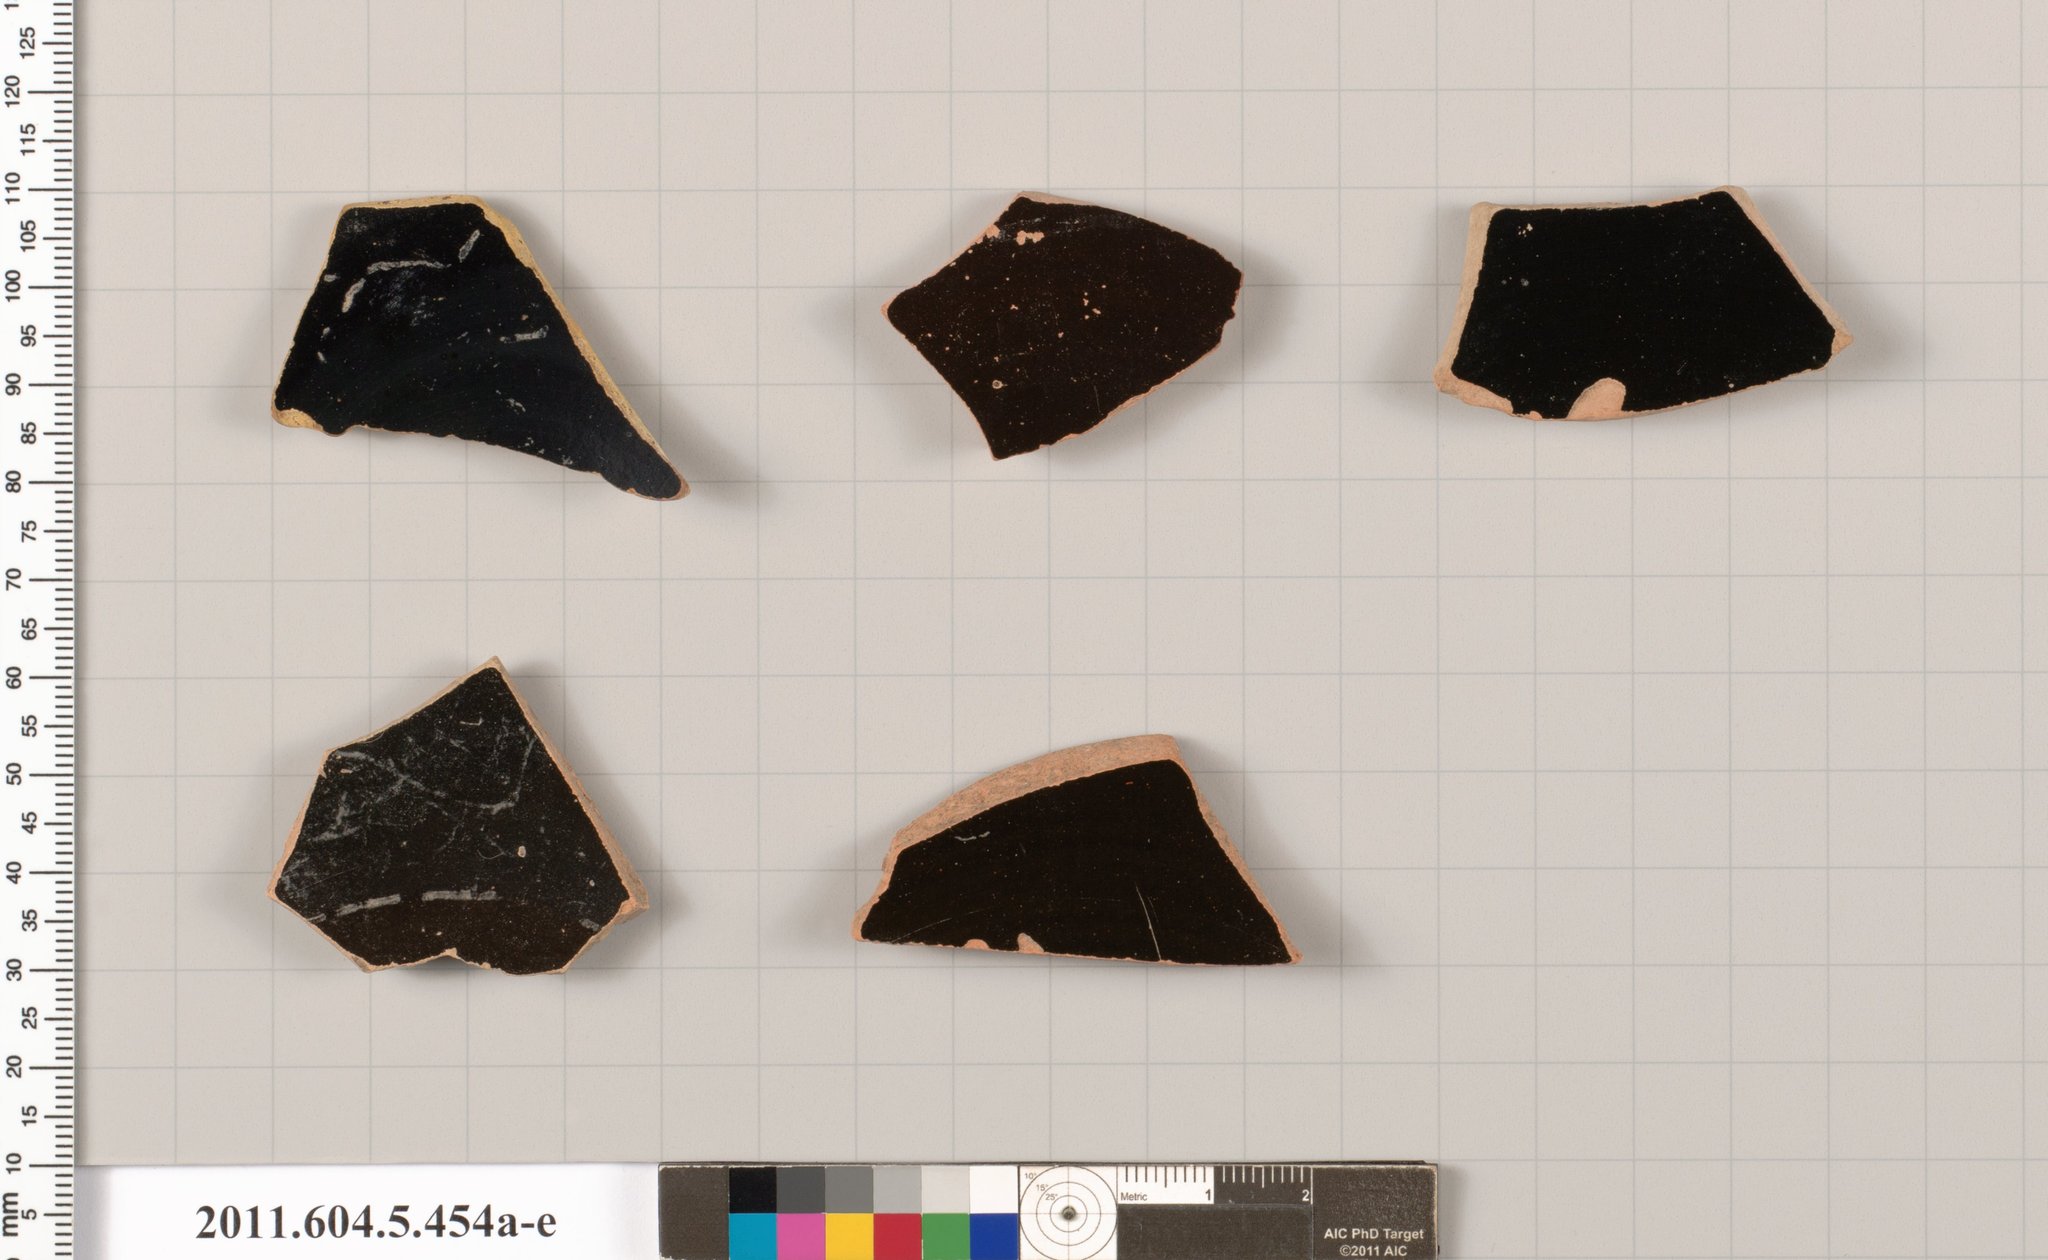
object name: kylix fragment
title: Terracotta fragments of kylikes (drinking cups)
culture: greek, attic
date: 600-401 BCE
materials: terracotta